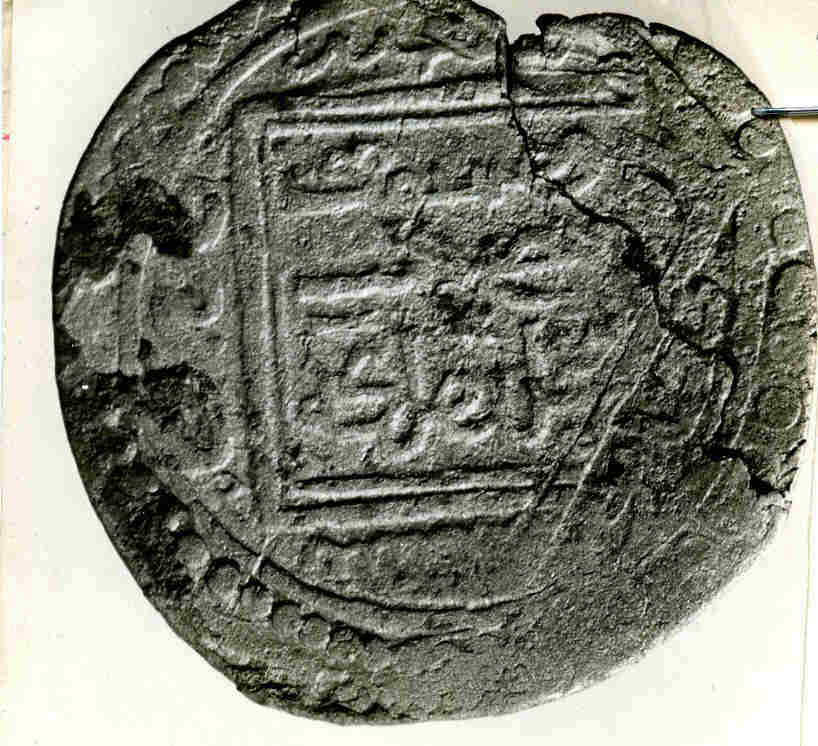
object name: coin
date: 1301-1400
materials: copper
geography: nishapur